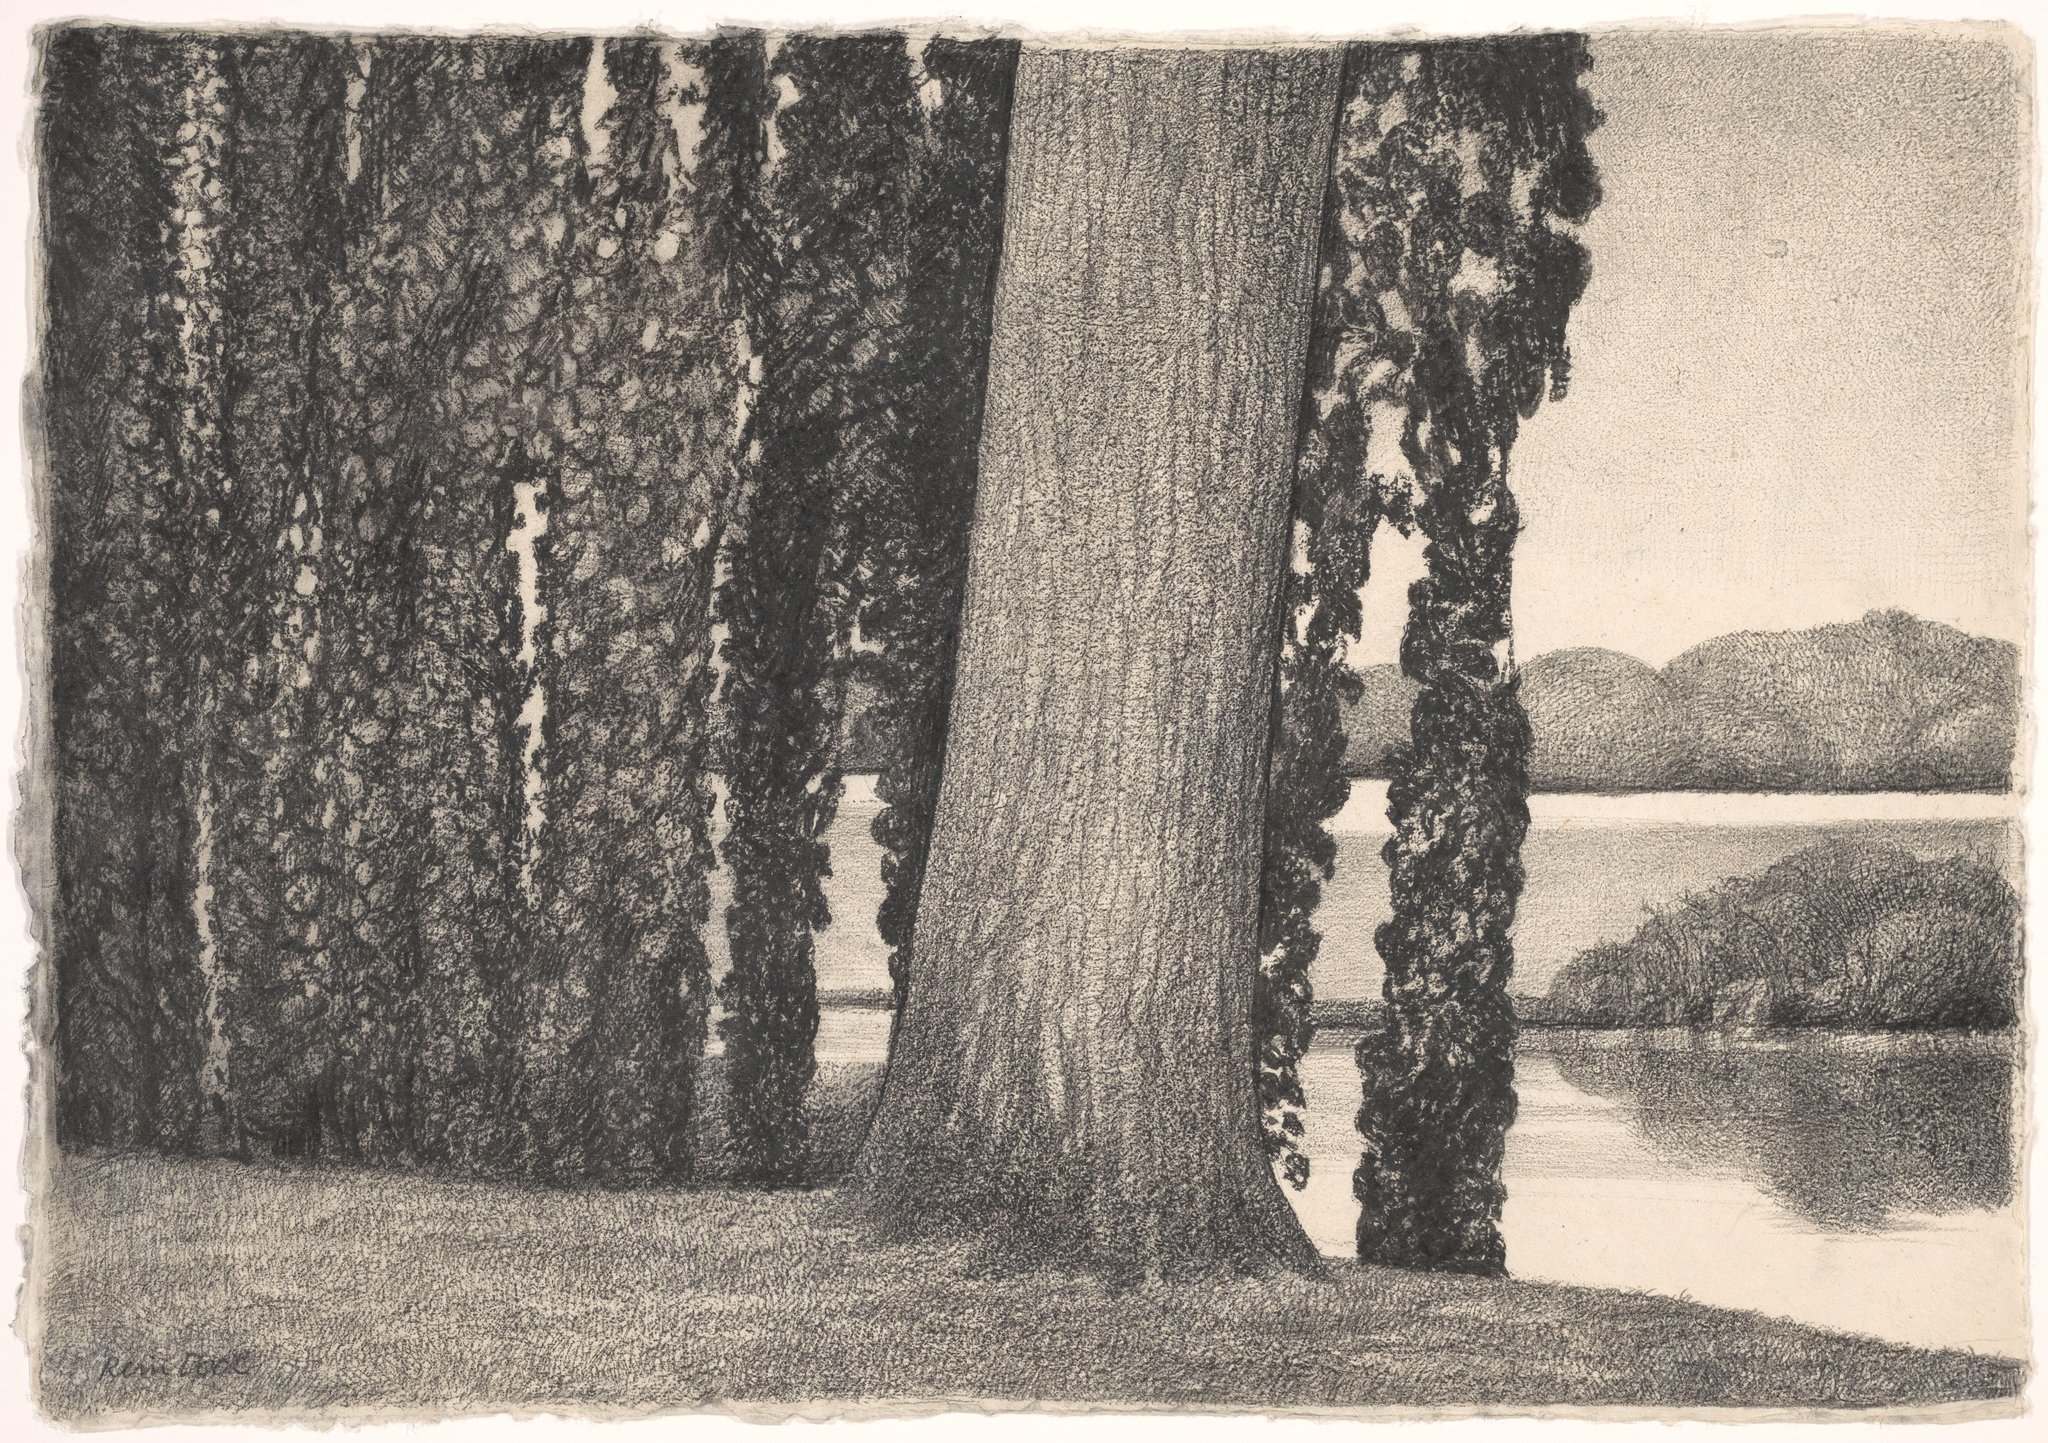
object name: drawing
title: Begroeide bomen in Dordtwijk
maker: rein dool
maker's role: draughtsman, painter, print maker, sculptor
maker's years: 1933-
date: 2013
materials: charcoal, paper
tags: dordrecht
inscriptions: signature